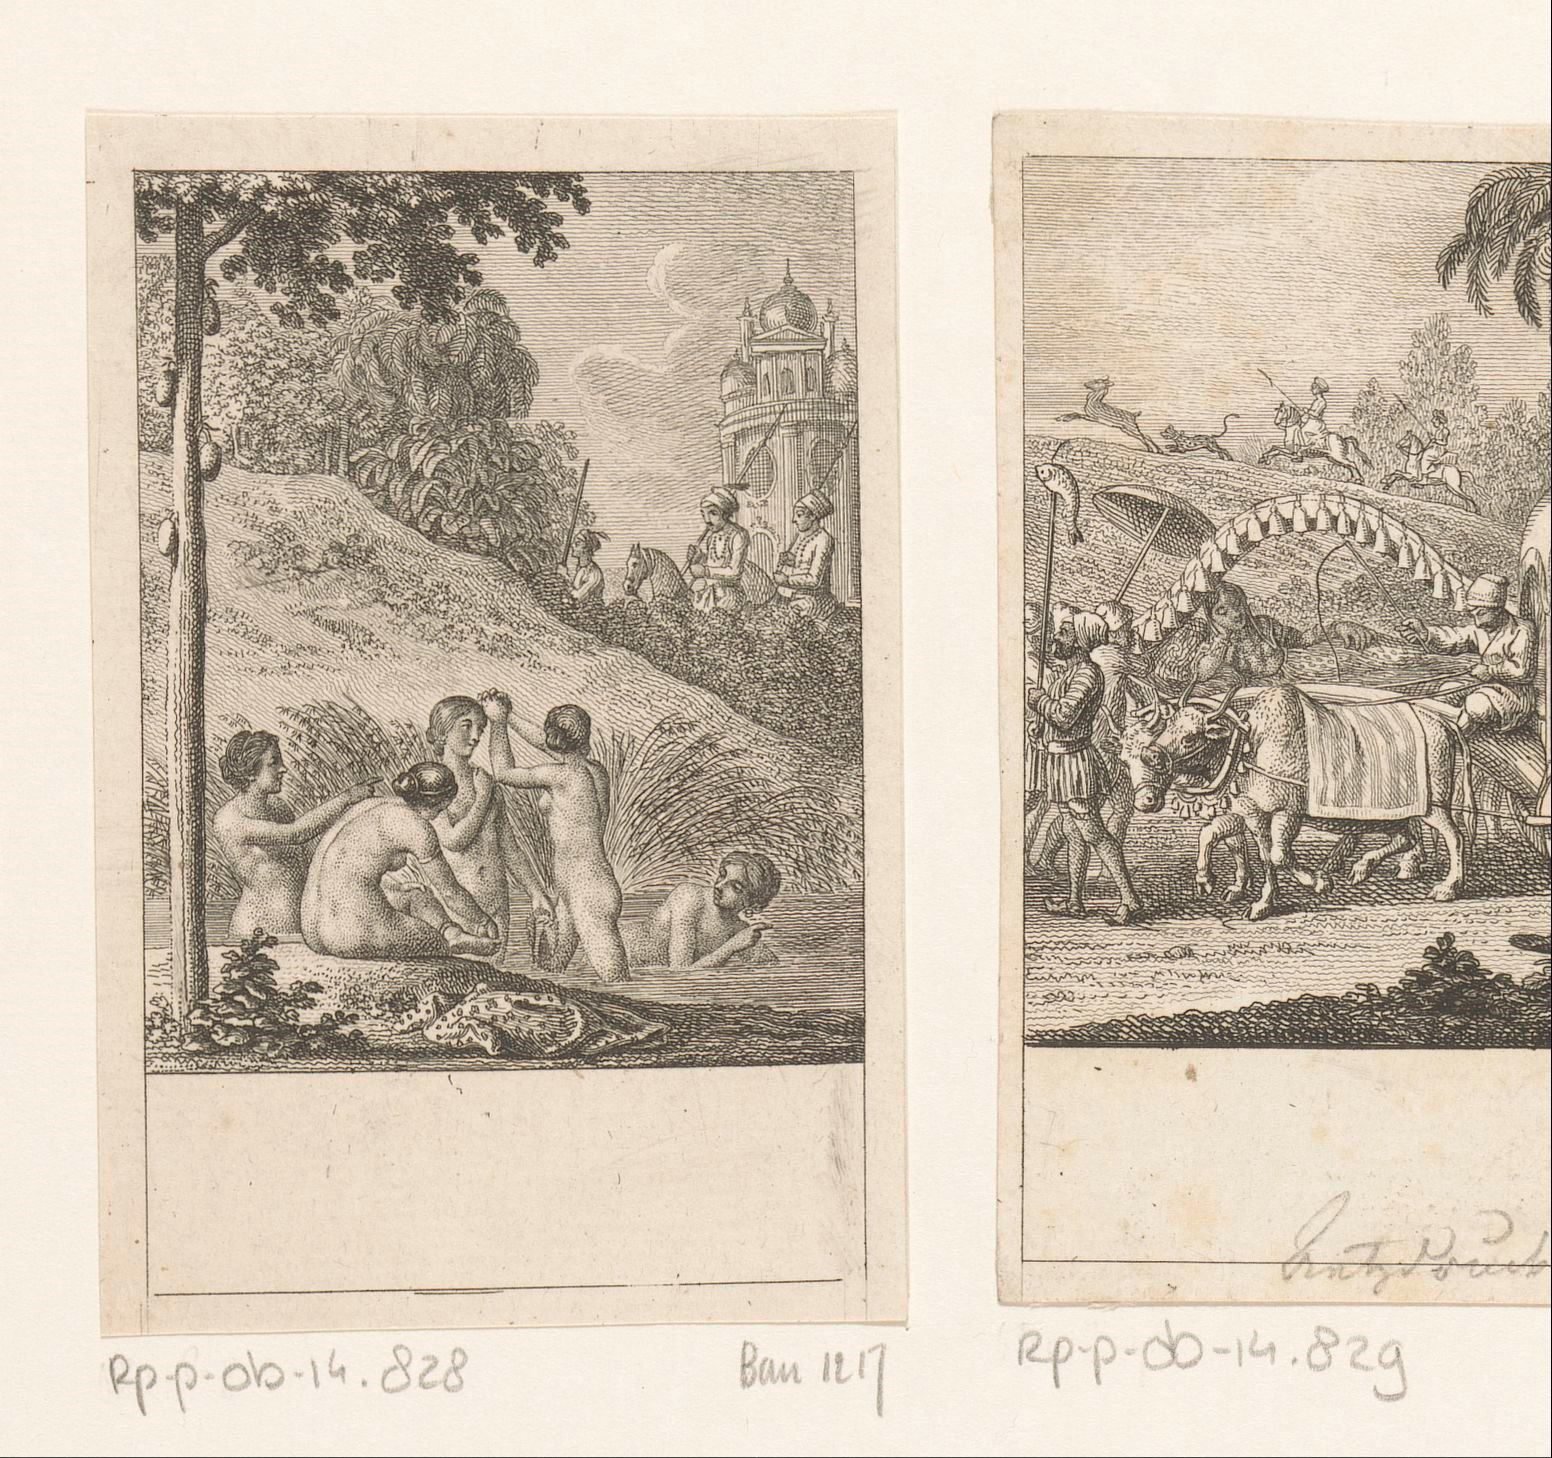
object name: print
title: Bajadère of het Indiase bad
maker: daniel nikolaus chodowiecki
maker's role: draughtsman, print maker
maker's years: 1726-1801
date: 1786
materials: paper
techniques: etching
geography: berlin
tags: taking a bath - aa - in the open air, asiatic races and peoples: indians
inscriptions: collector's mark: Lugt 2228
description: Latere staat gebruikt voor: Sprengel, Matthias Christian. Historisch-genealogischer Calender, oder, Jahrbuch der merkwürdigsten neuen Welt-Begebenheiten für 1786. Leipzig: Zur Messe bey Haude und Spener von Berlin, s.a.